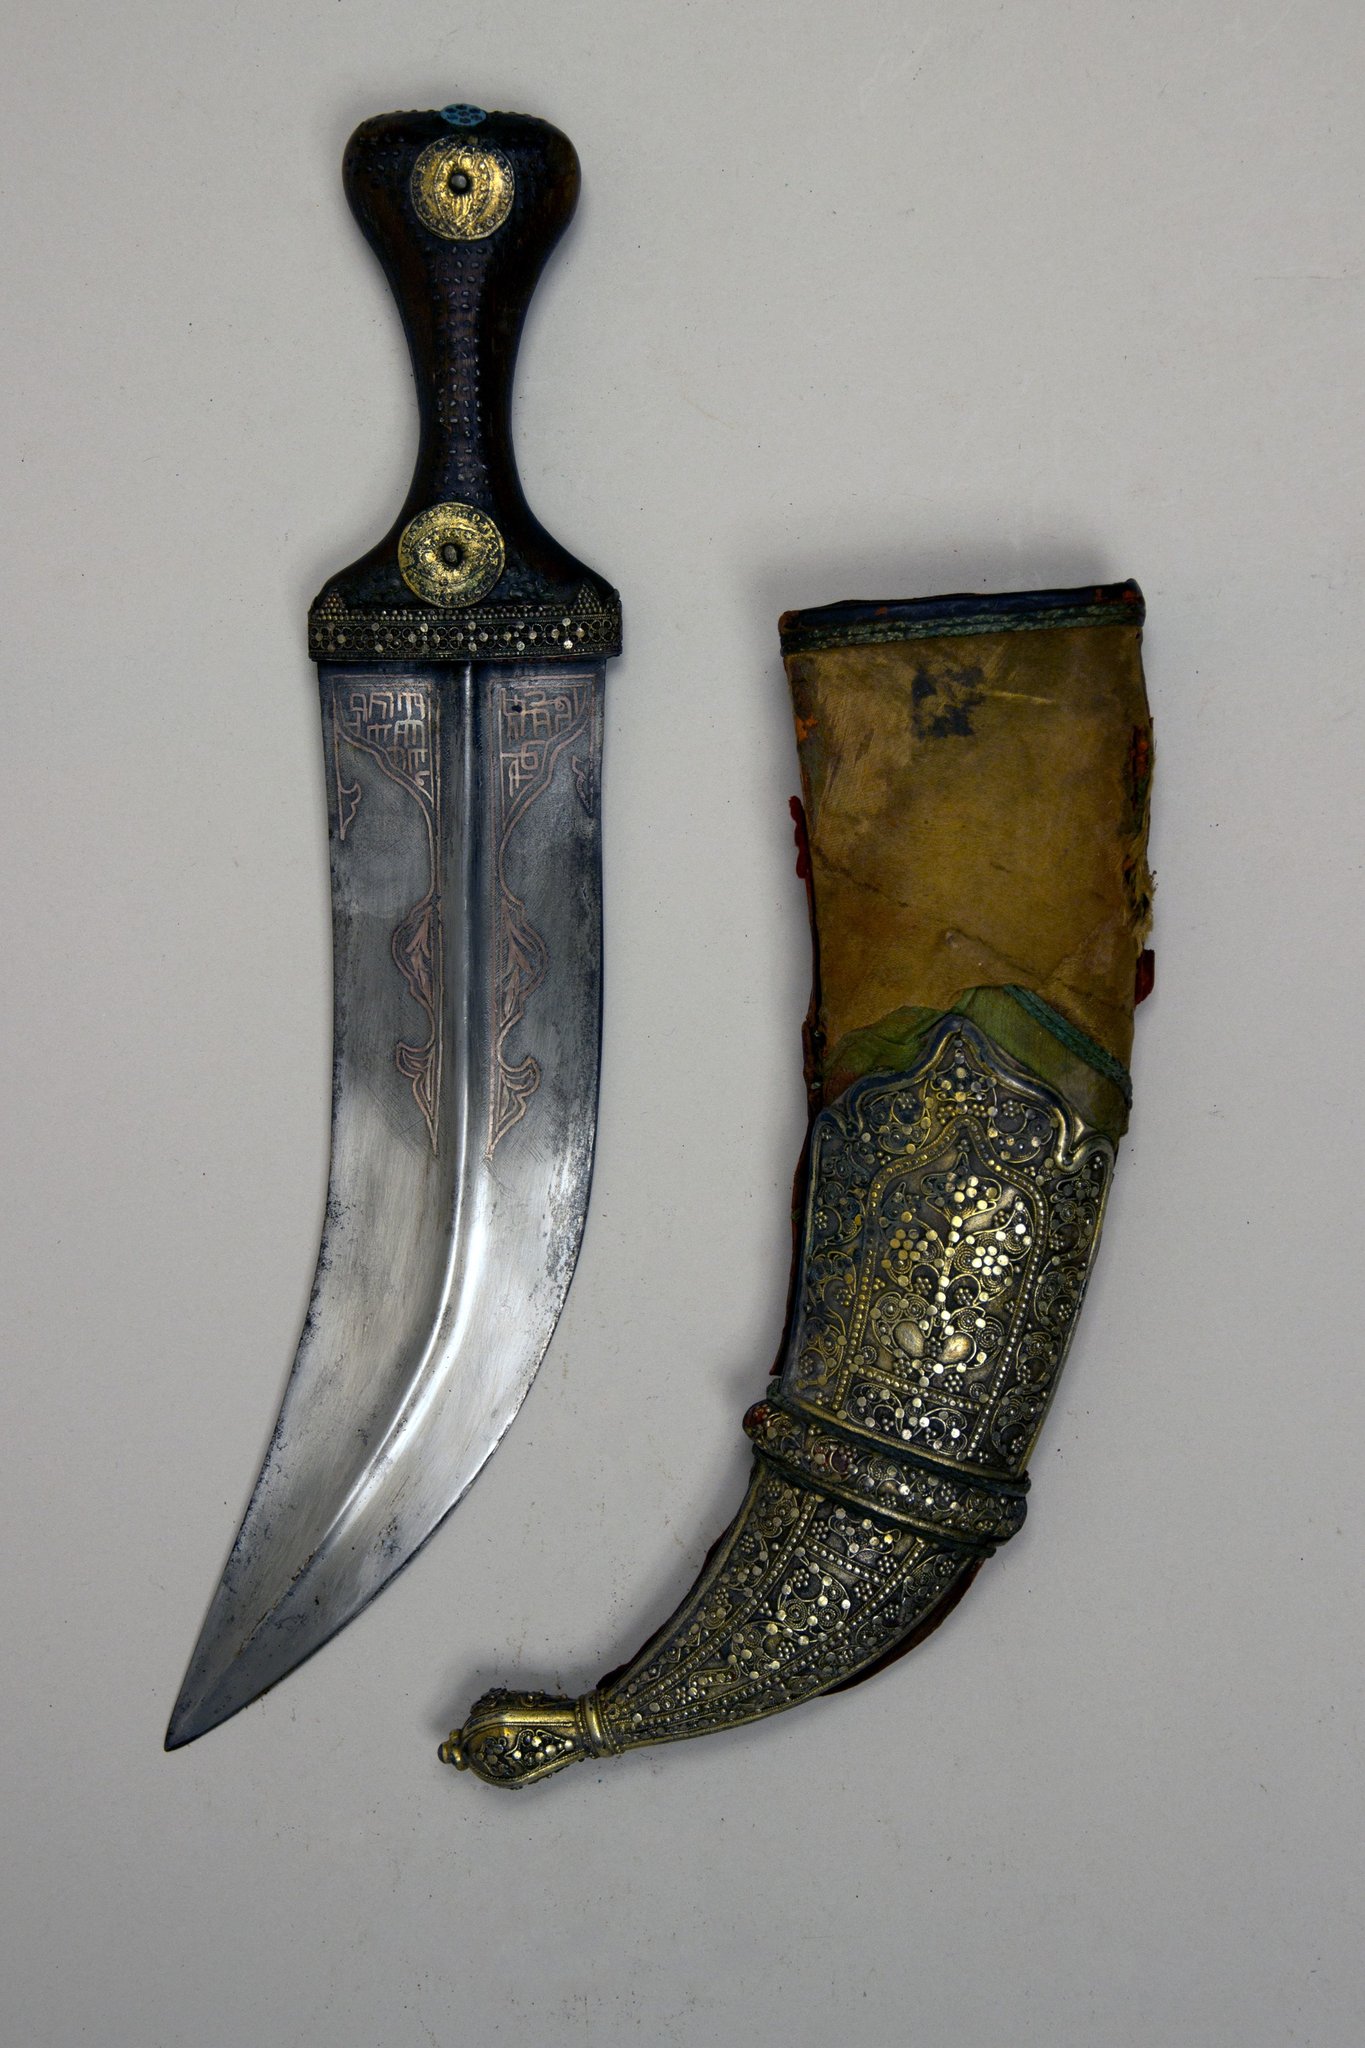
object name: dagger jambiya with sheath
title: Dagger (Jambiya) with Sheath and Belt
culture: arabian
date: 1701-1900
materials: brass, enamel, leather, silver, steel, textile, wood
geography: tanzania